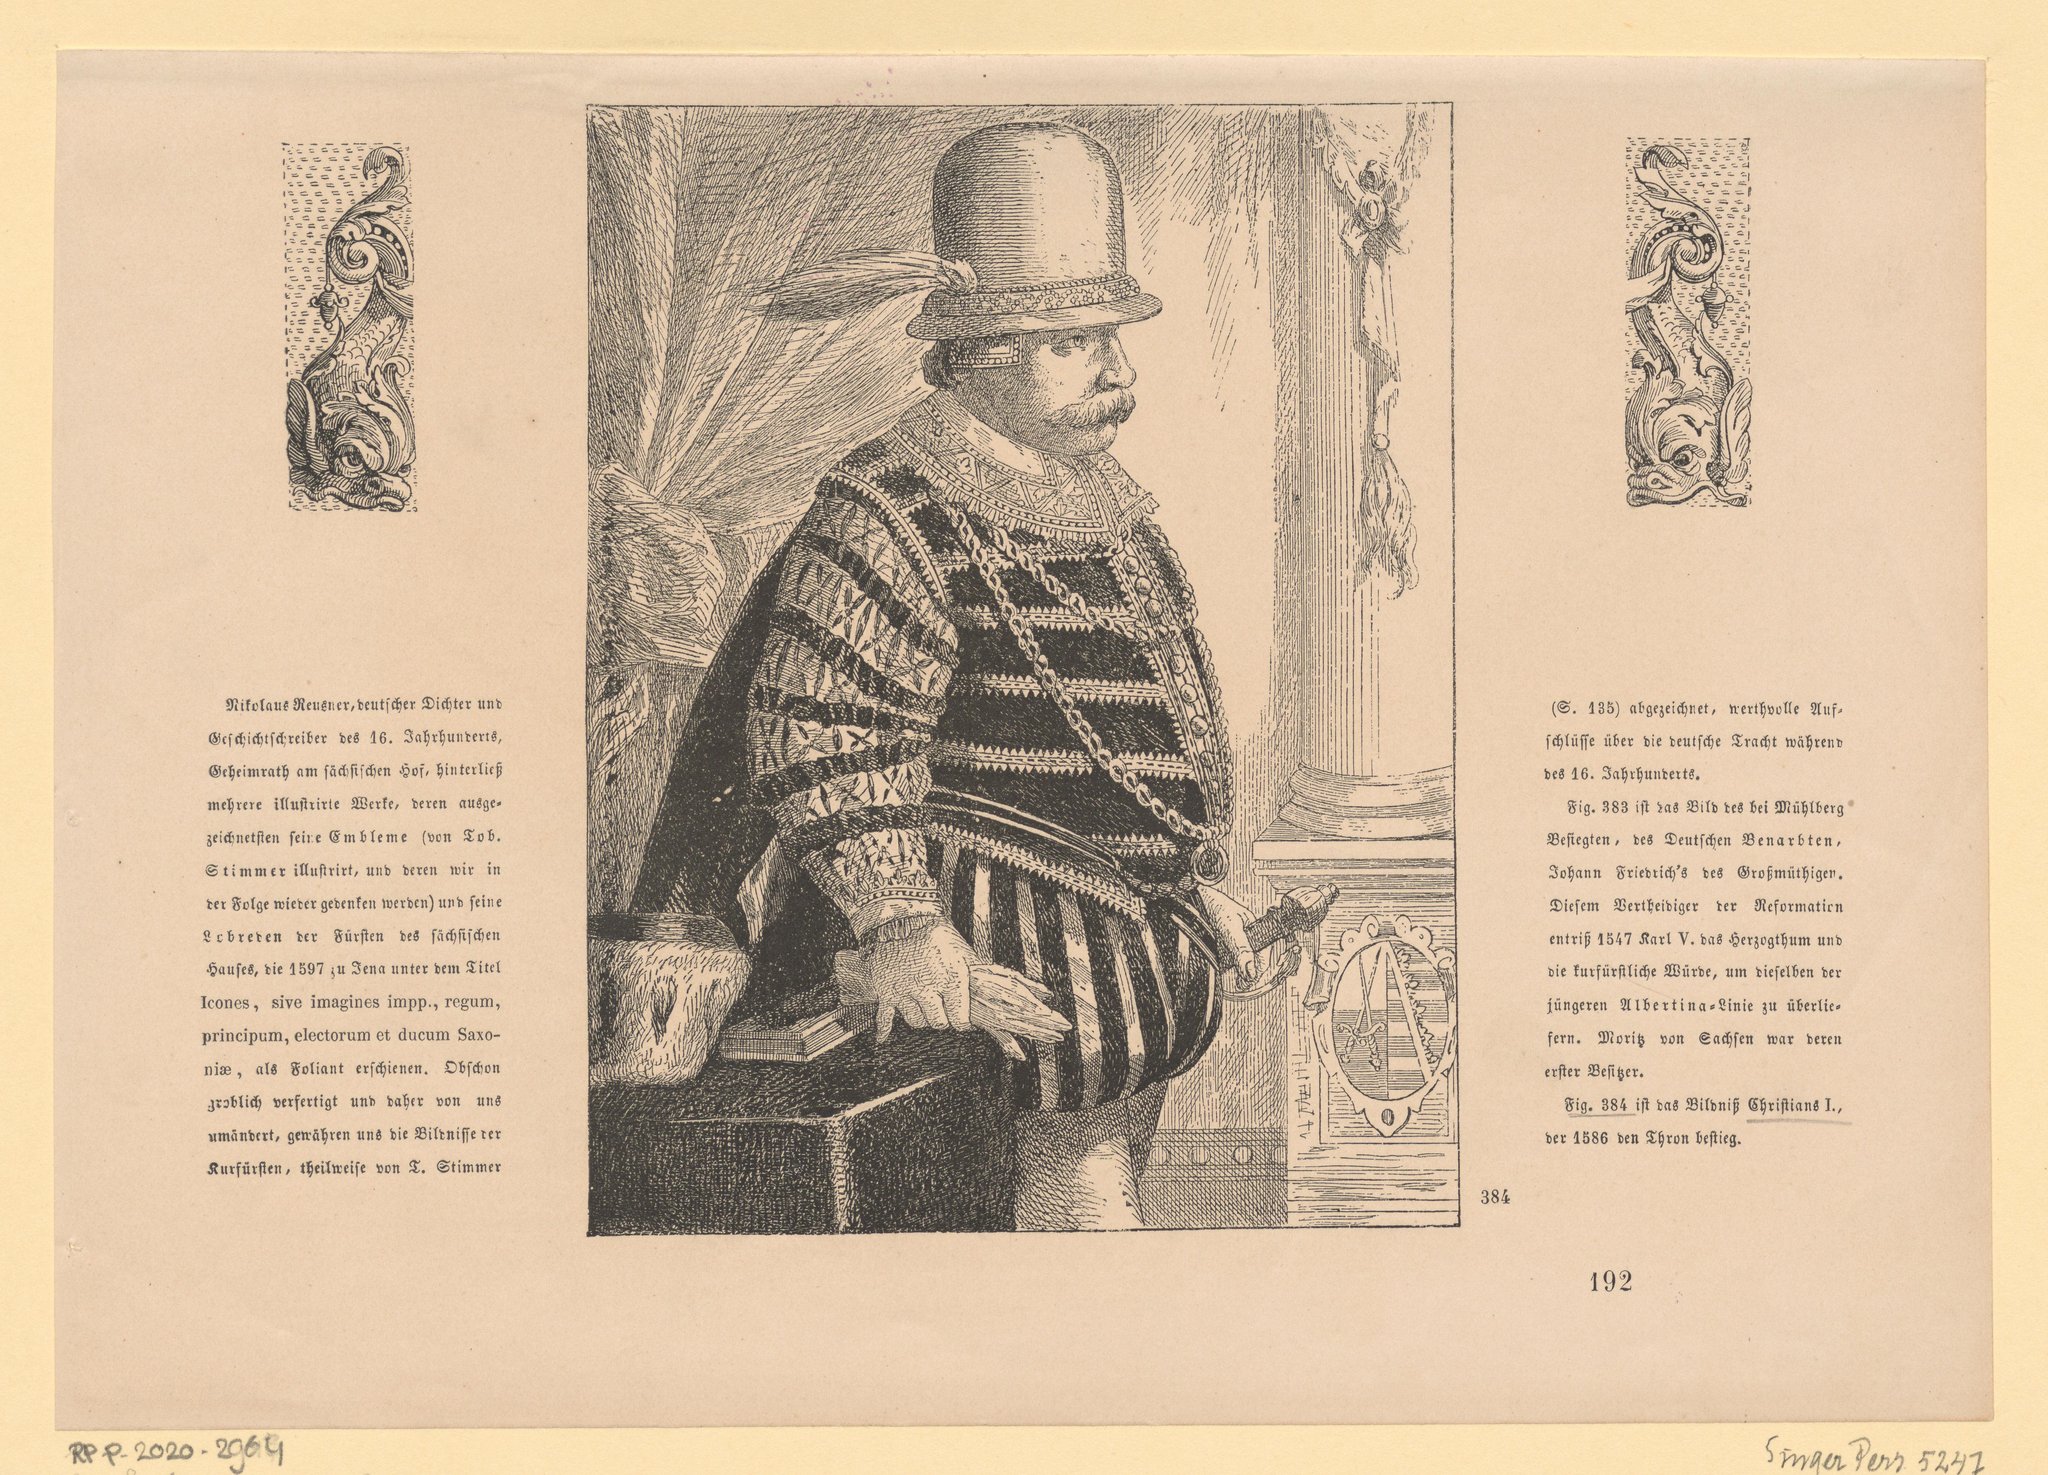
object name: print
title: Portret van Christiaan I van Saksen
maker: Anonymous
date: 1790-1900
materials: paper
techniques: engraving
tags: historical persons